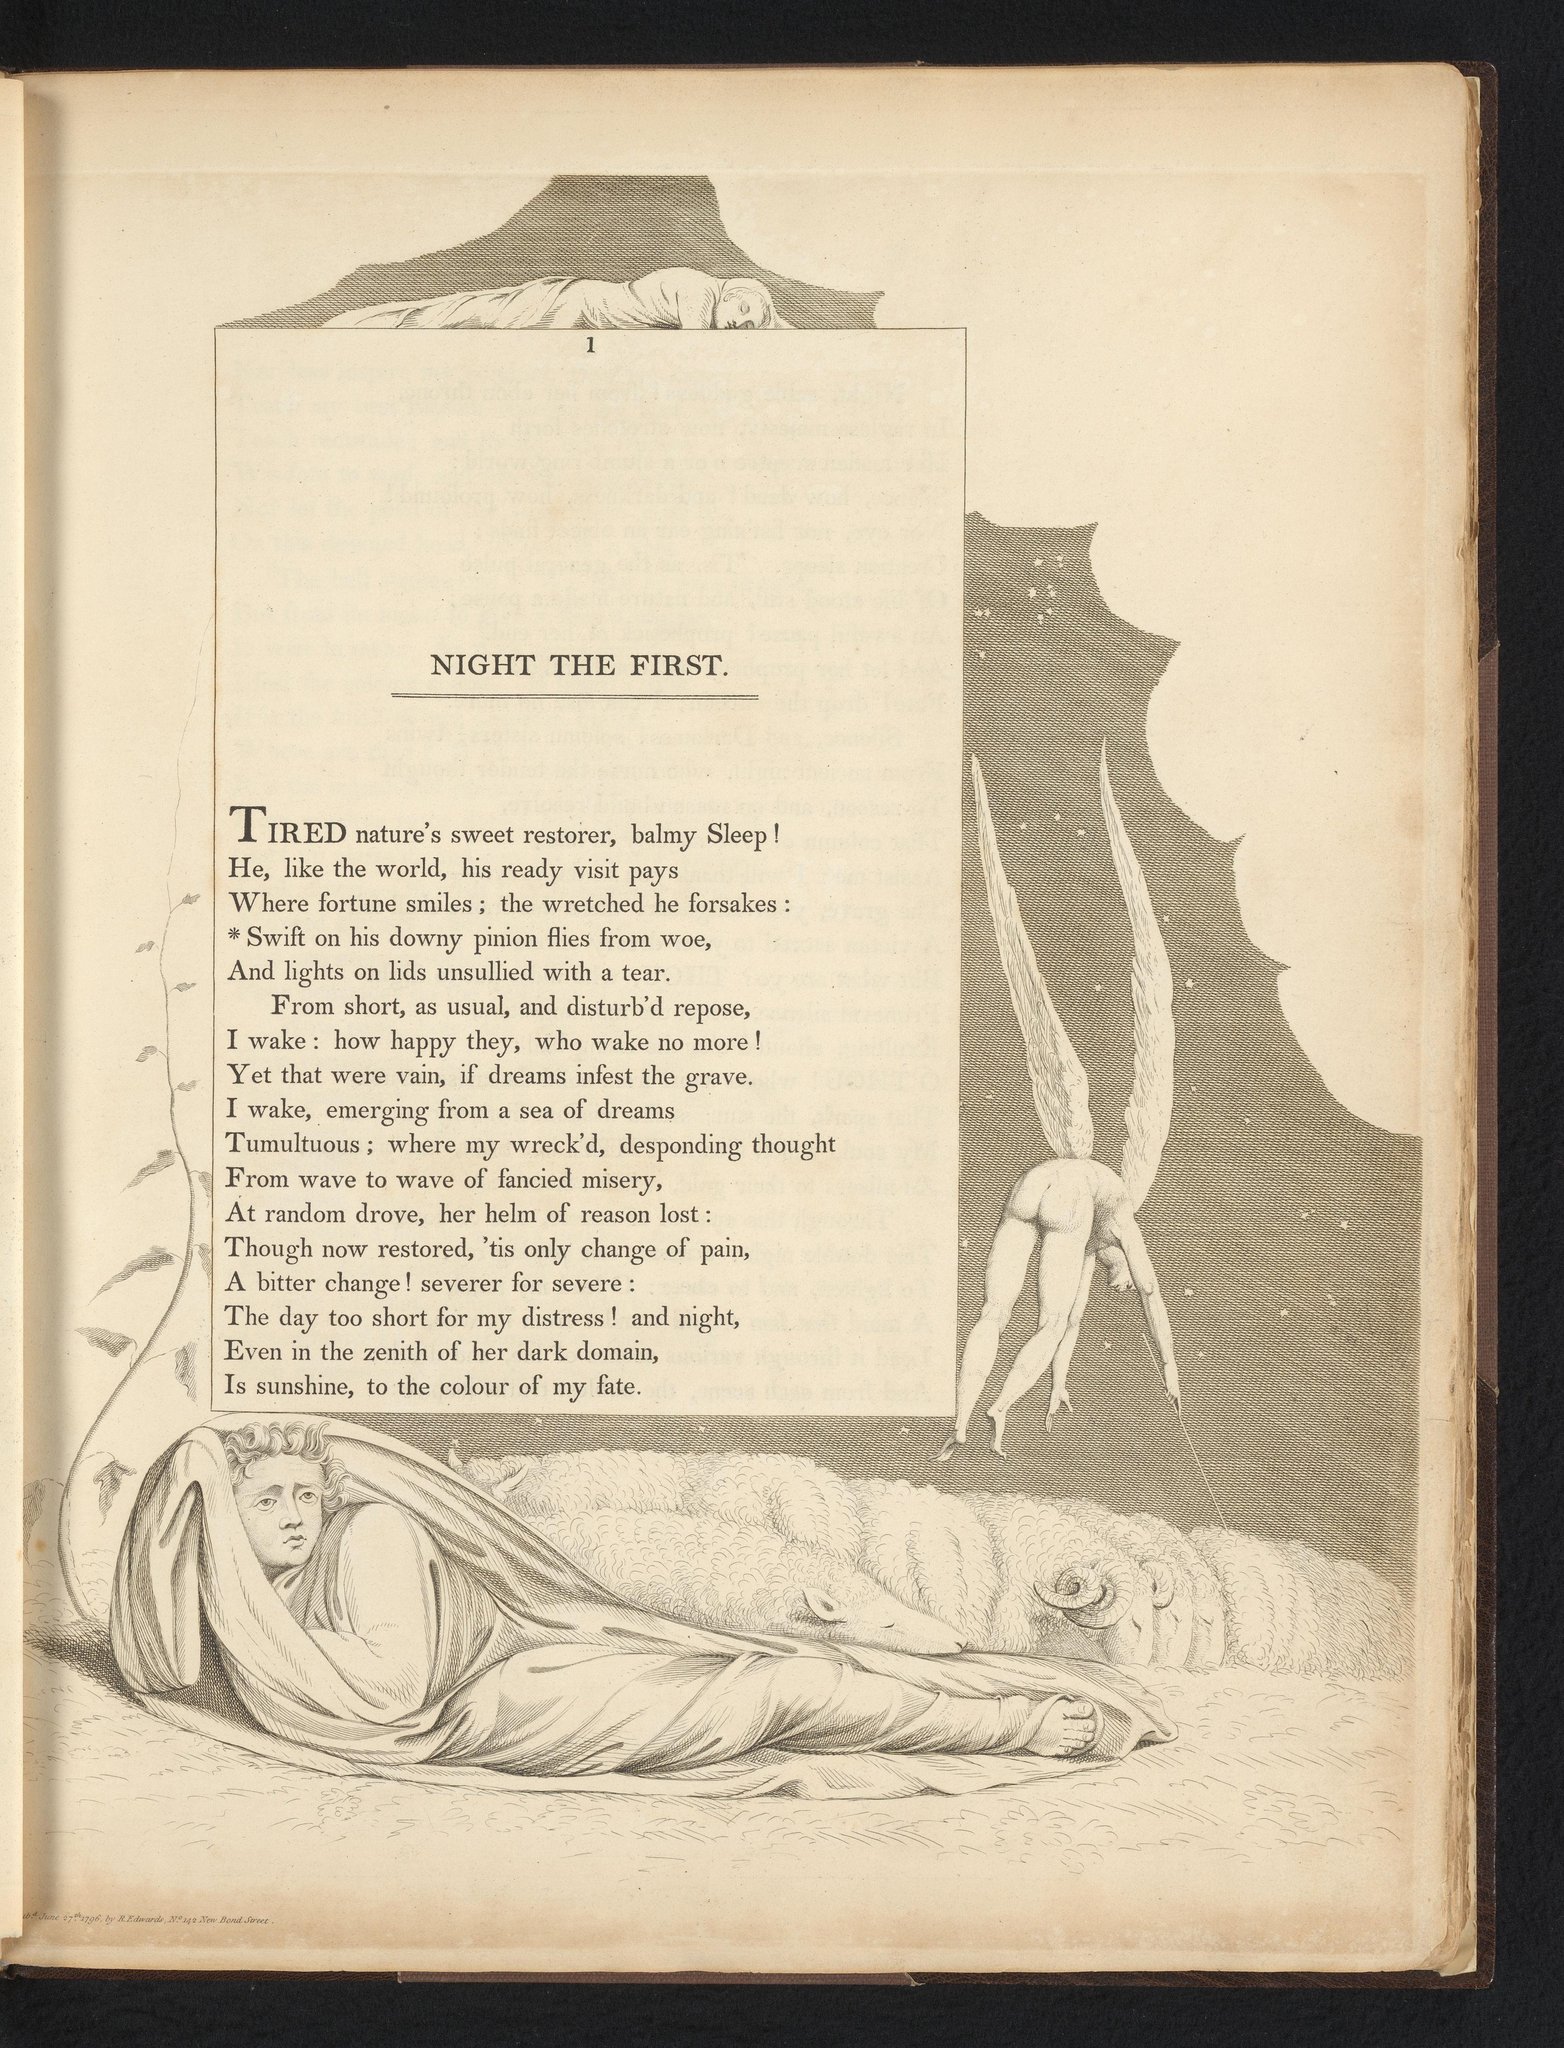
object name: print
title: Liggende man met engel en schapen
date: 1796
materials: paper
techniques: engraving, letterpress printing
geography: london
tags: adult man, sheep, sleeping on the ground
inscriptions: watermark, : ‘Night the first (...)’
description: Prent maakt deel uit van een boek, bladzijde 1. Tekst in het Engels op recto en verso.